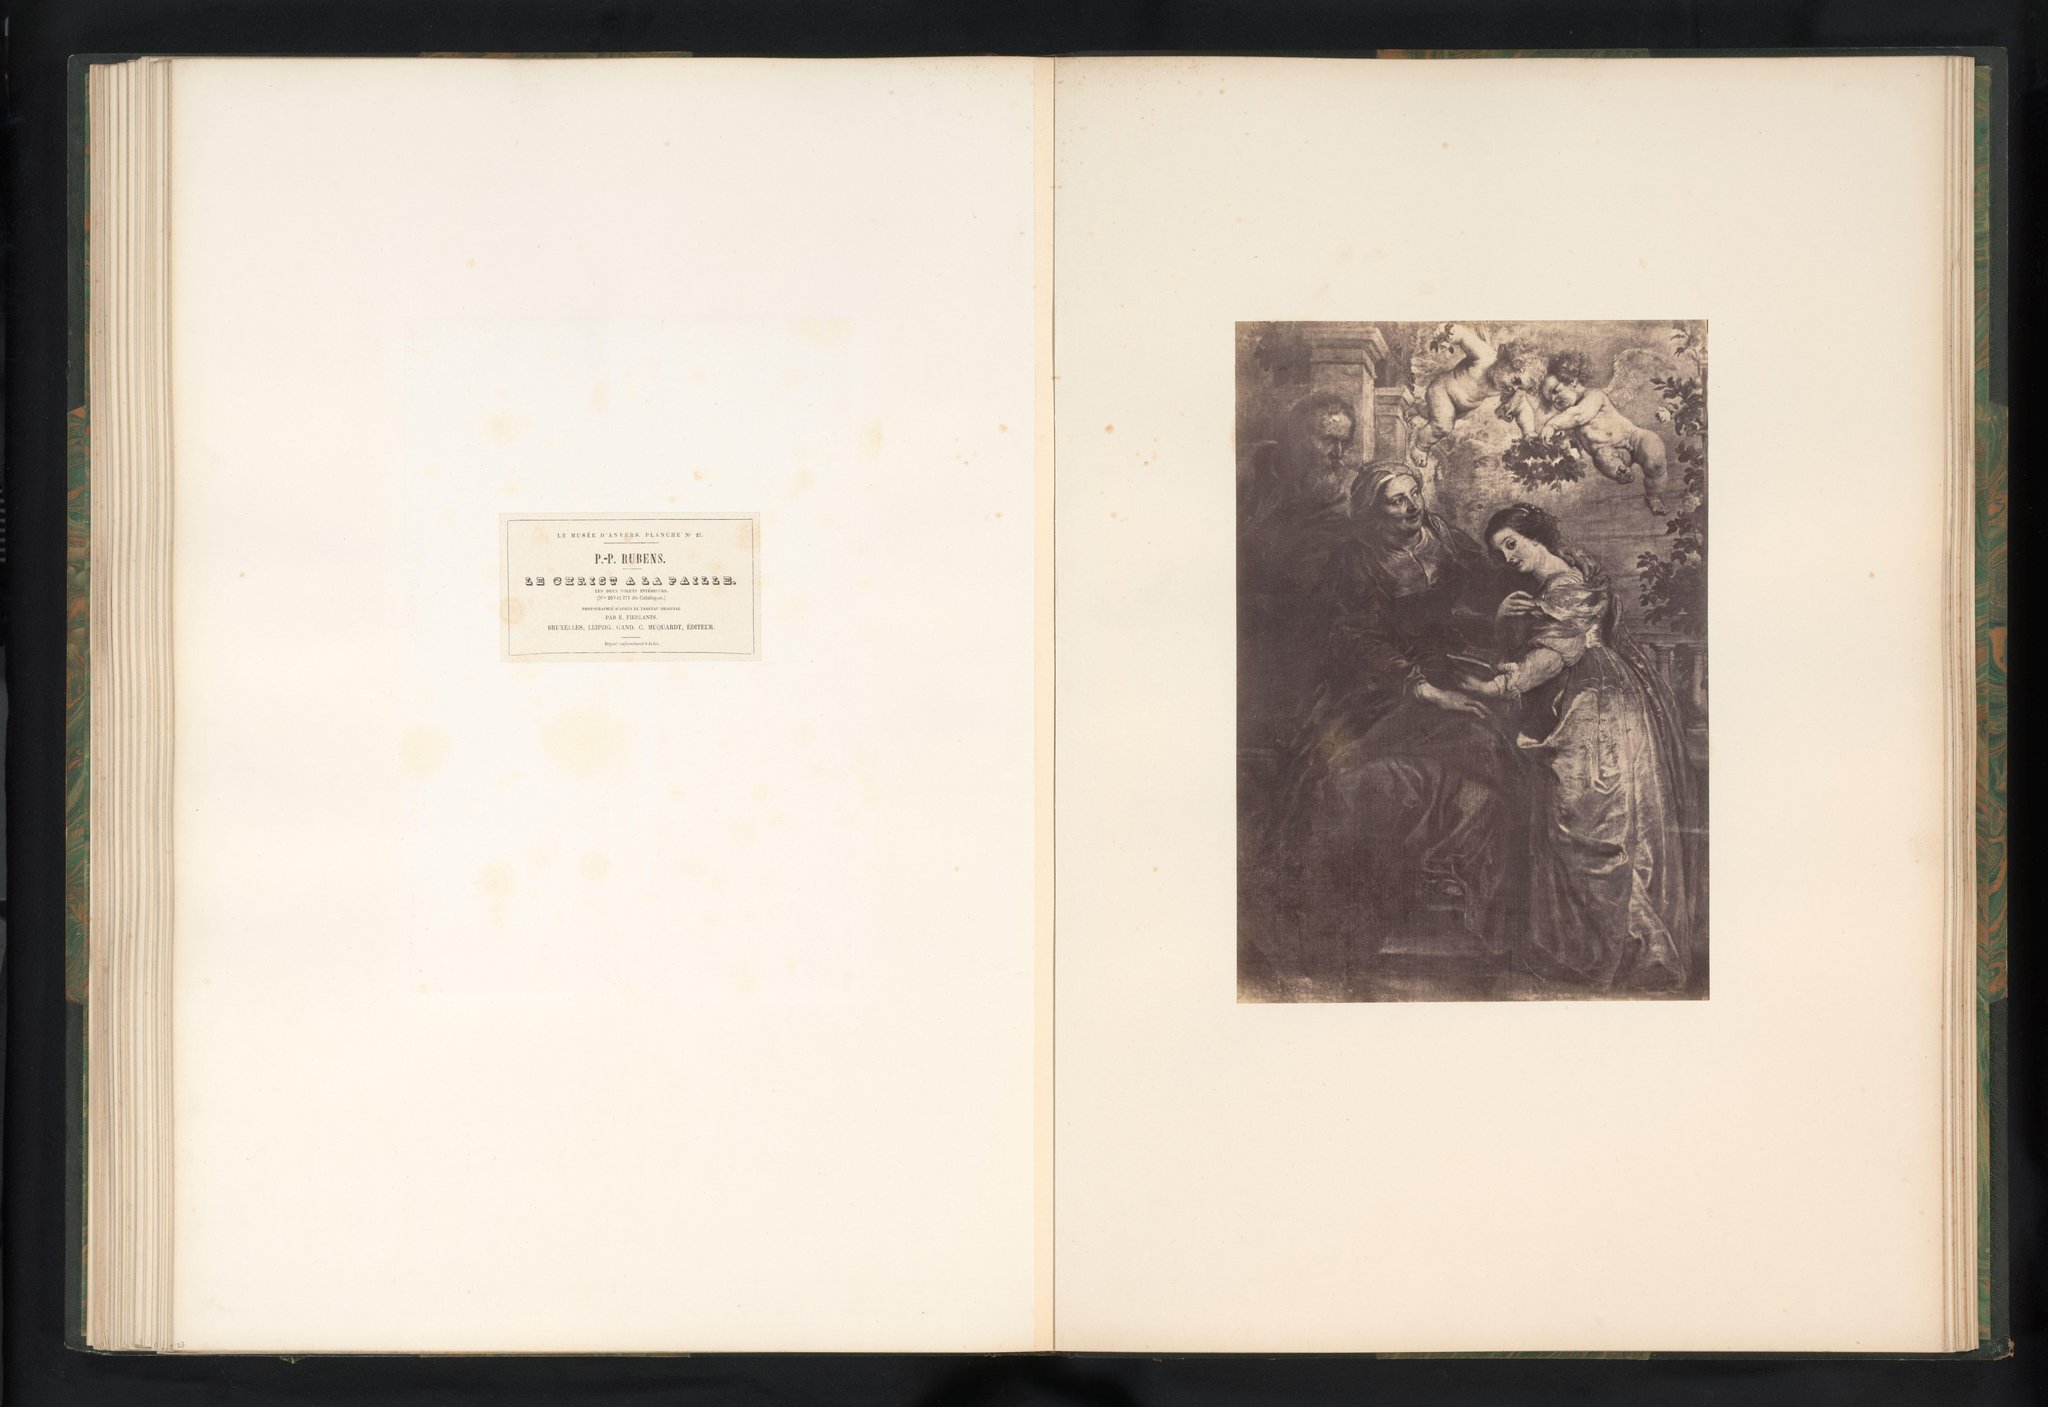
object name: photograph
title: Fotoreproductie van de Opvoeding van Maria door Peter Paul Rubens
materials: photographic support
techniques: albumen print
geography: brussels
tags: education of mary